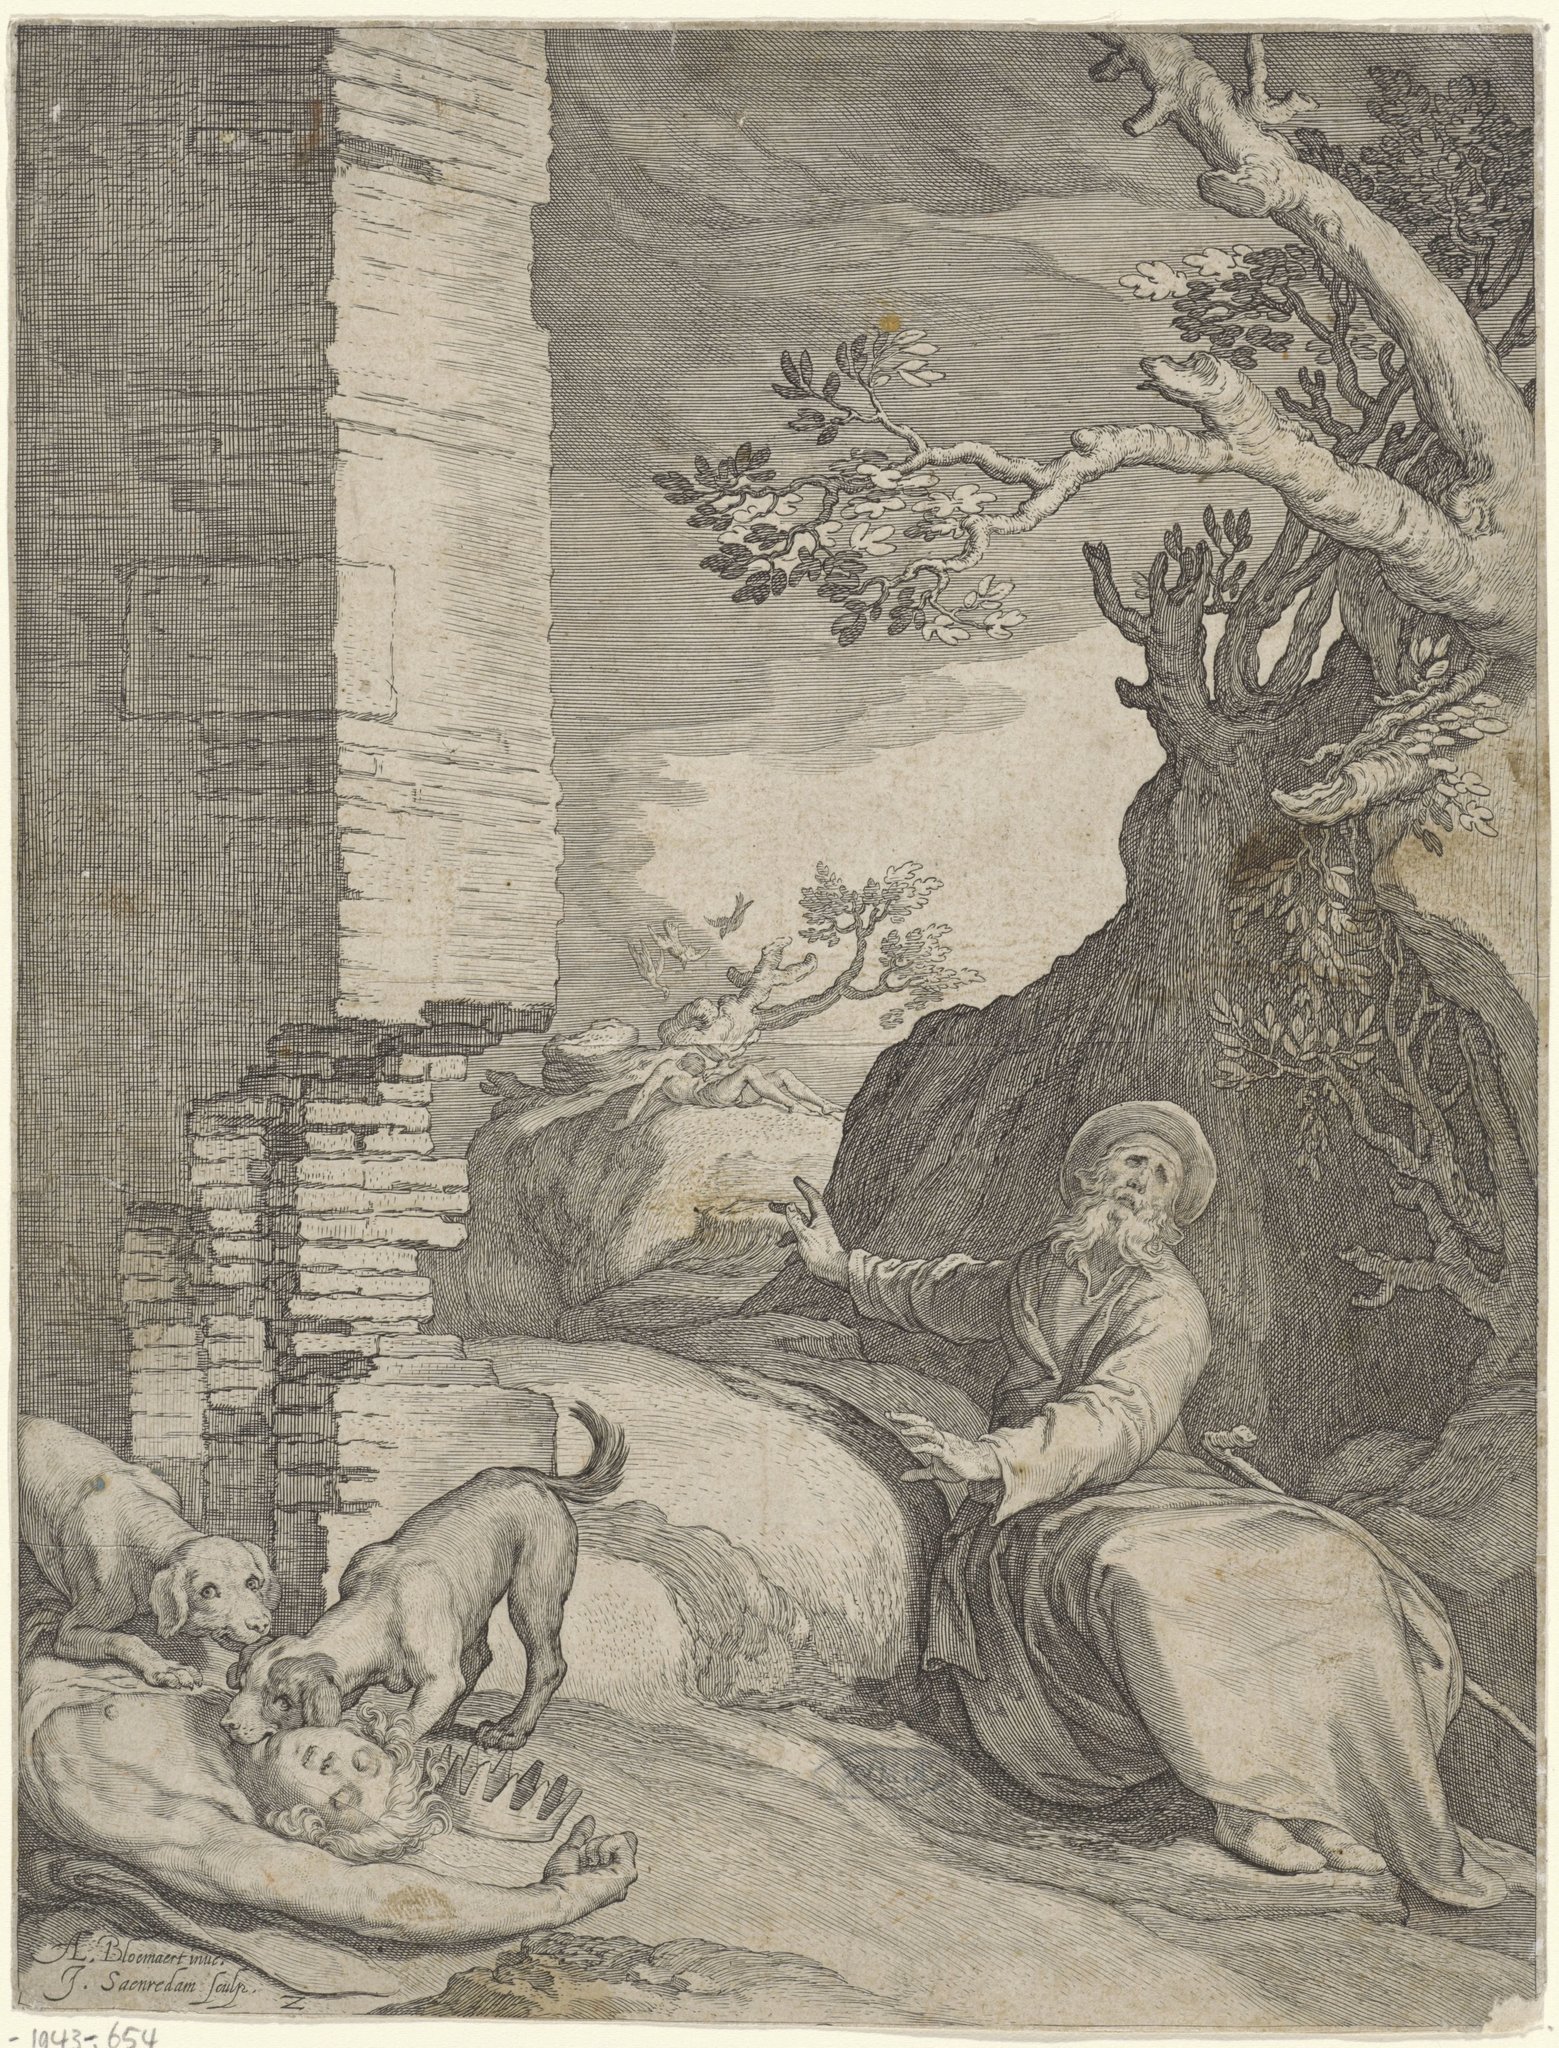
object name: print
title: Vier scènes uit het leven van de profeten Achia en Elia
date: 1604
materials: chalk, paper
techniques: engraving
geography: assendelft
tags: jeroboam's wife in disguise visits the old and blind ahijah, but he, having been warned by god, recognizes her; he predicts the death of her son and israel's punishment for jeroboam's sin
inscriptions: collector's mark: Lugt 2228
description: De profeet Achia zit bij een boom naast een ruïne. Rondom hem fragmenten van de onheilsprofetie die hij de vrouw van koning Jerobeam voorspelde. In de linkeronderhoek wordt een van de zonen van koning Jerobeam door honden verscheurd. Op de achtergrond wordt een van de zonen van koning Jerobeam door roofvogels opgegeten.